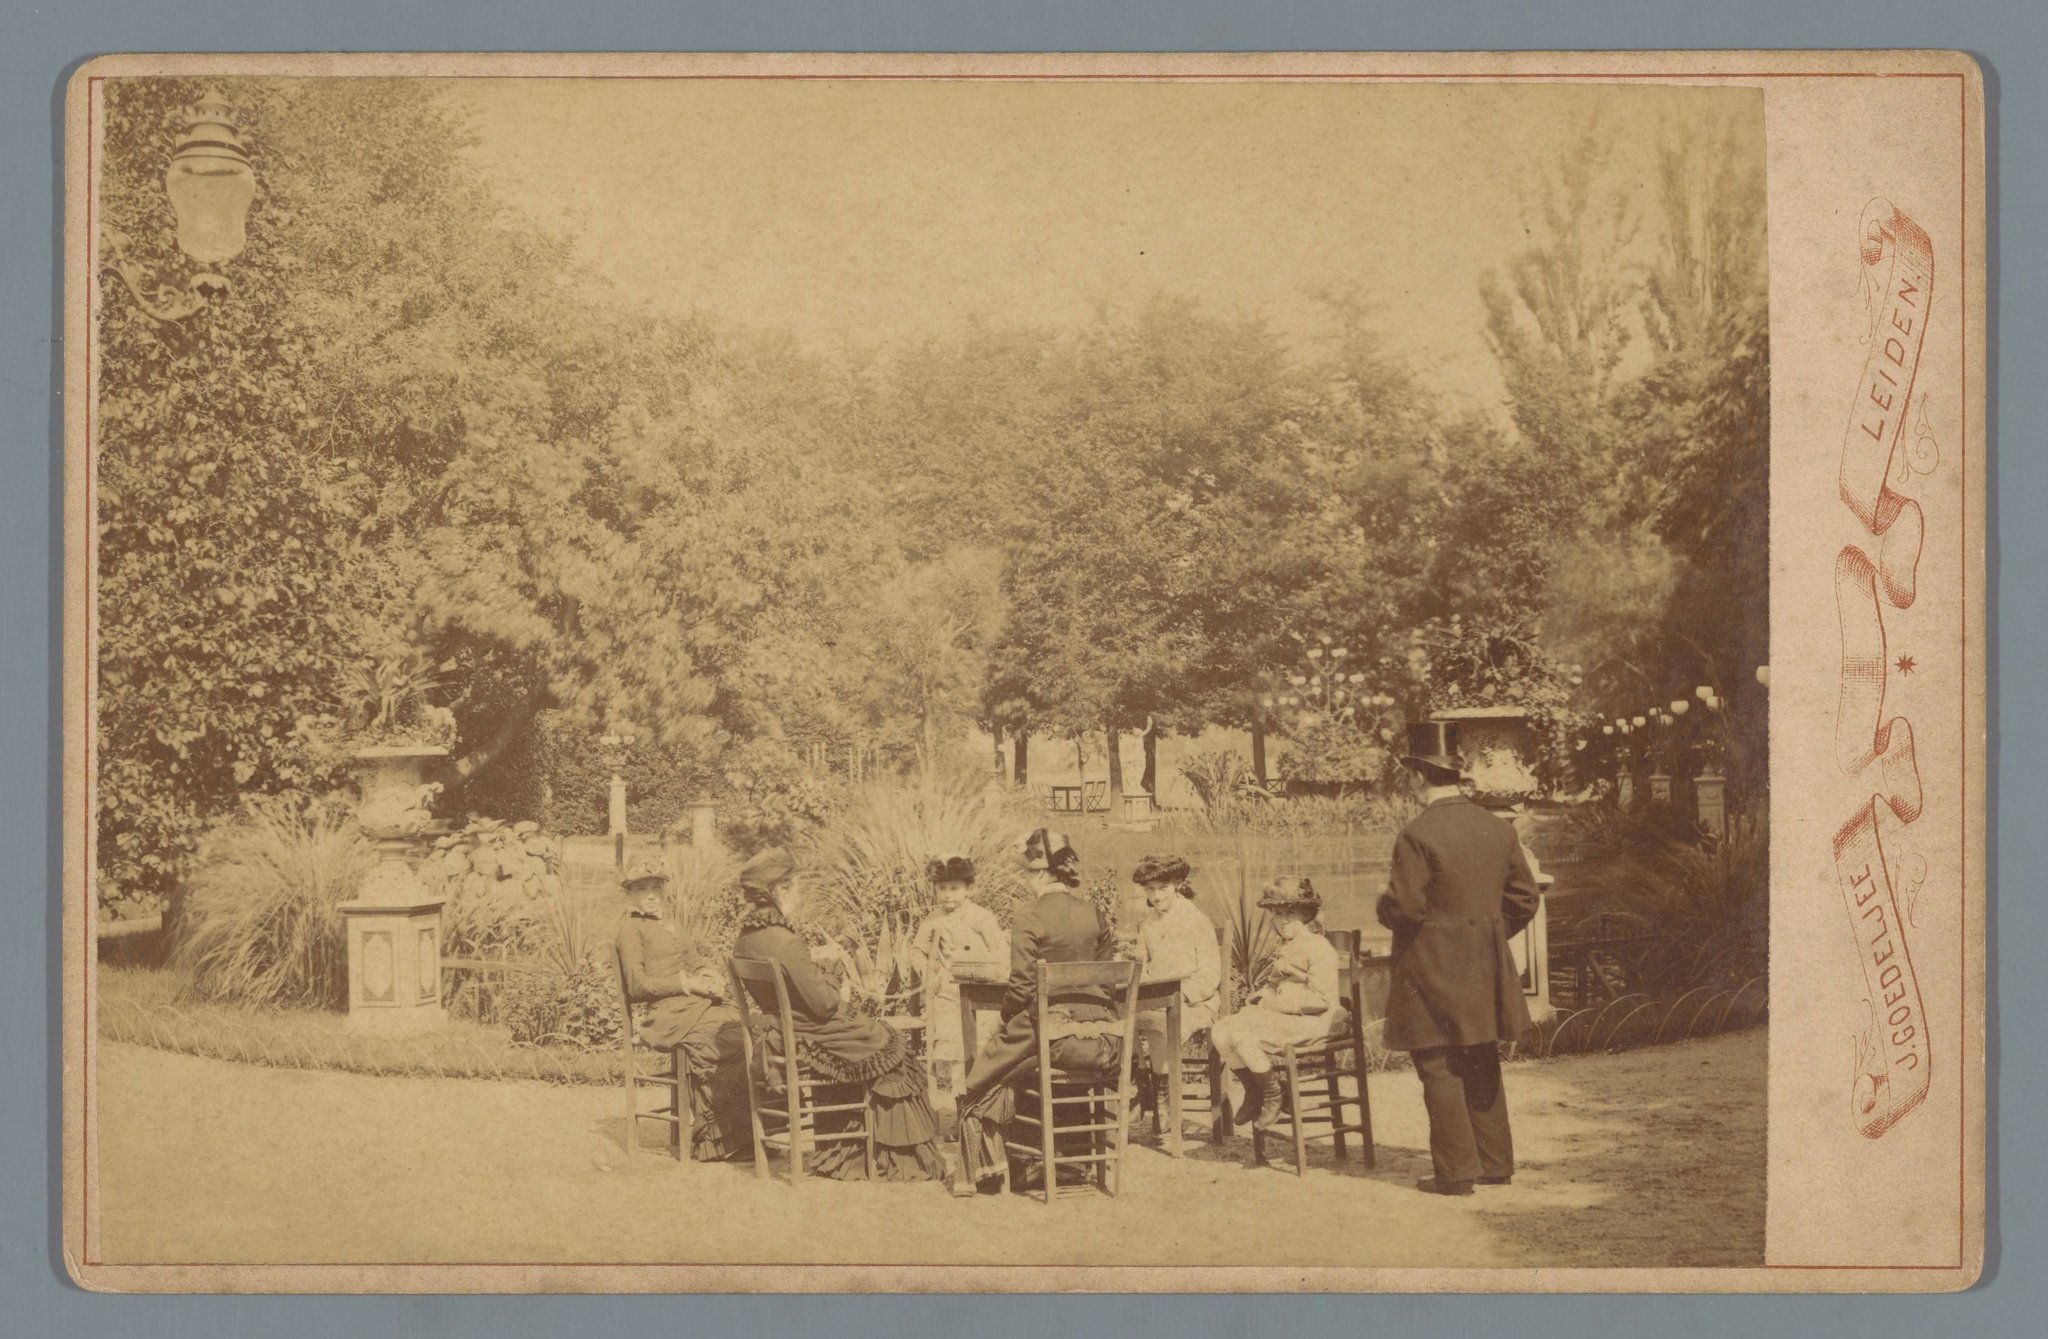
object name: cabinet photograph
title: Gezelschap rond een tafel te Leiden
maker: jan goedeljee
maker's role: fotograaf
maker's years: 1824-1905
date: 1850-1900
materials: cardboard, photographic support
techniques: albumen print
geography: leiden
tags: garden, leiden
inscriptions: retailer's mark: ‘J. GOEDELJEE/ POTOGRAAF (...) LEIDEN/ Hoogewoerd 160, nabij de Plantage.’